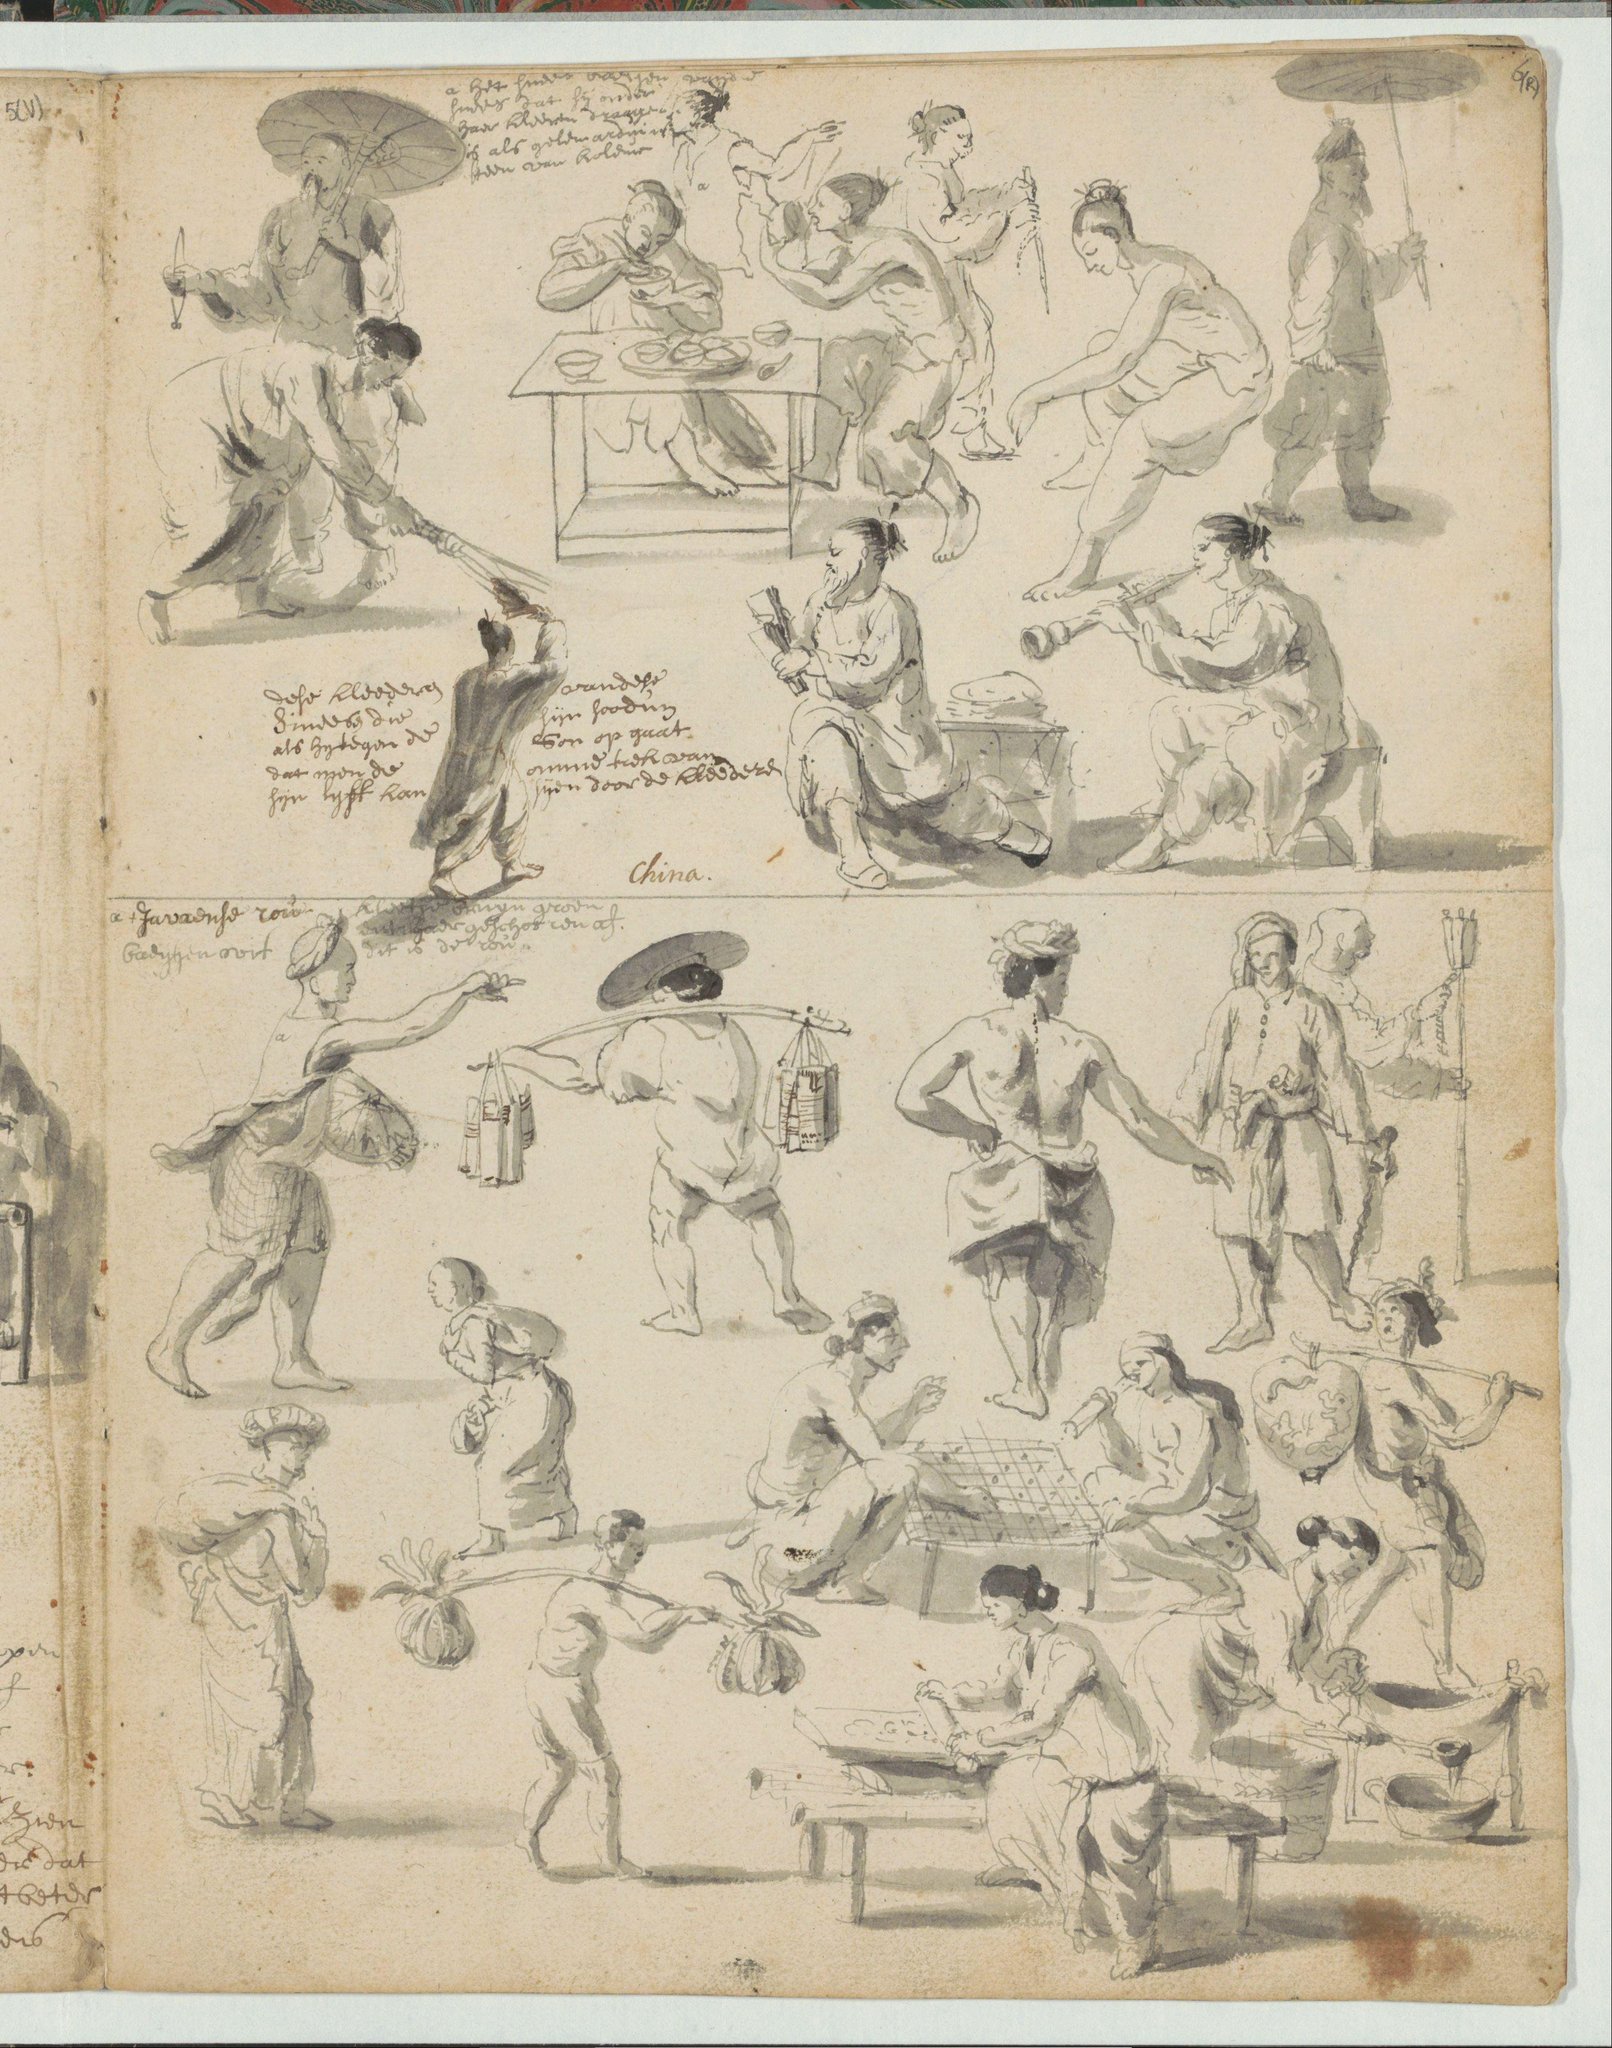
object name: sketchbook leaf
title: Studieblad met Chinese en Javaanse mannen en vrouwen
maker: wouter schouten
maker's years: 1638-1704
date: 1660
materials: ink, paper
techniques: brush, pen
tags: asiatic races and peoples (indonesians), carrying something, asiatic races and peoples (with name), board-games, parasol, sunshade, eating, preparation of food, java, china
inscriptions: annotation: ‘[...]/ China/ Javaansche rou/ [...]’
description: De mannen en vrouwen houden zich bezig met verschillende activiteiten: ze dragen lasten en parasols, spelen bordspellen en bereiden en eten voedsel. Blad 6 recto van een katern van 10 bladen afkomstig uit een schetsboek.